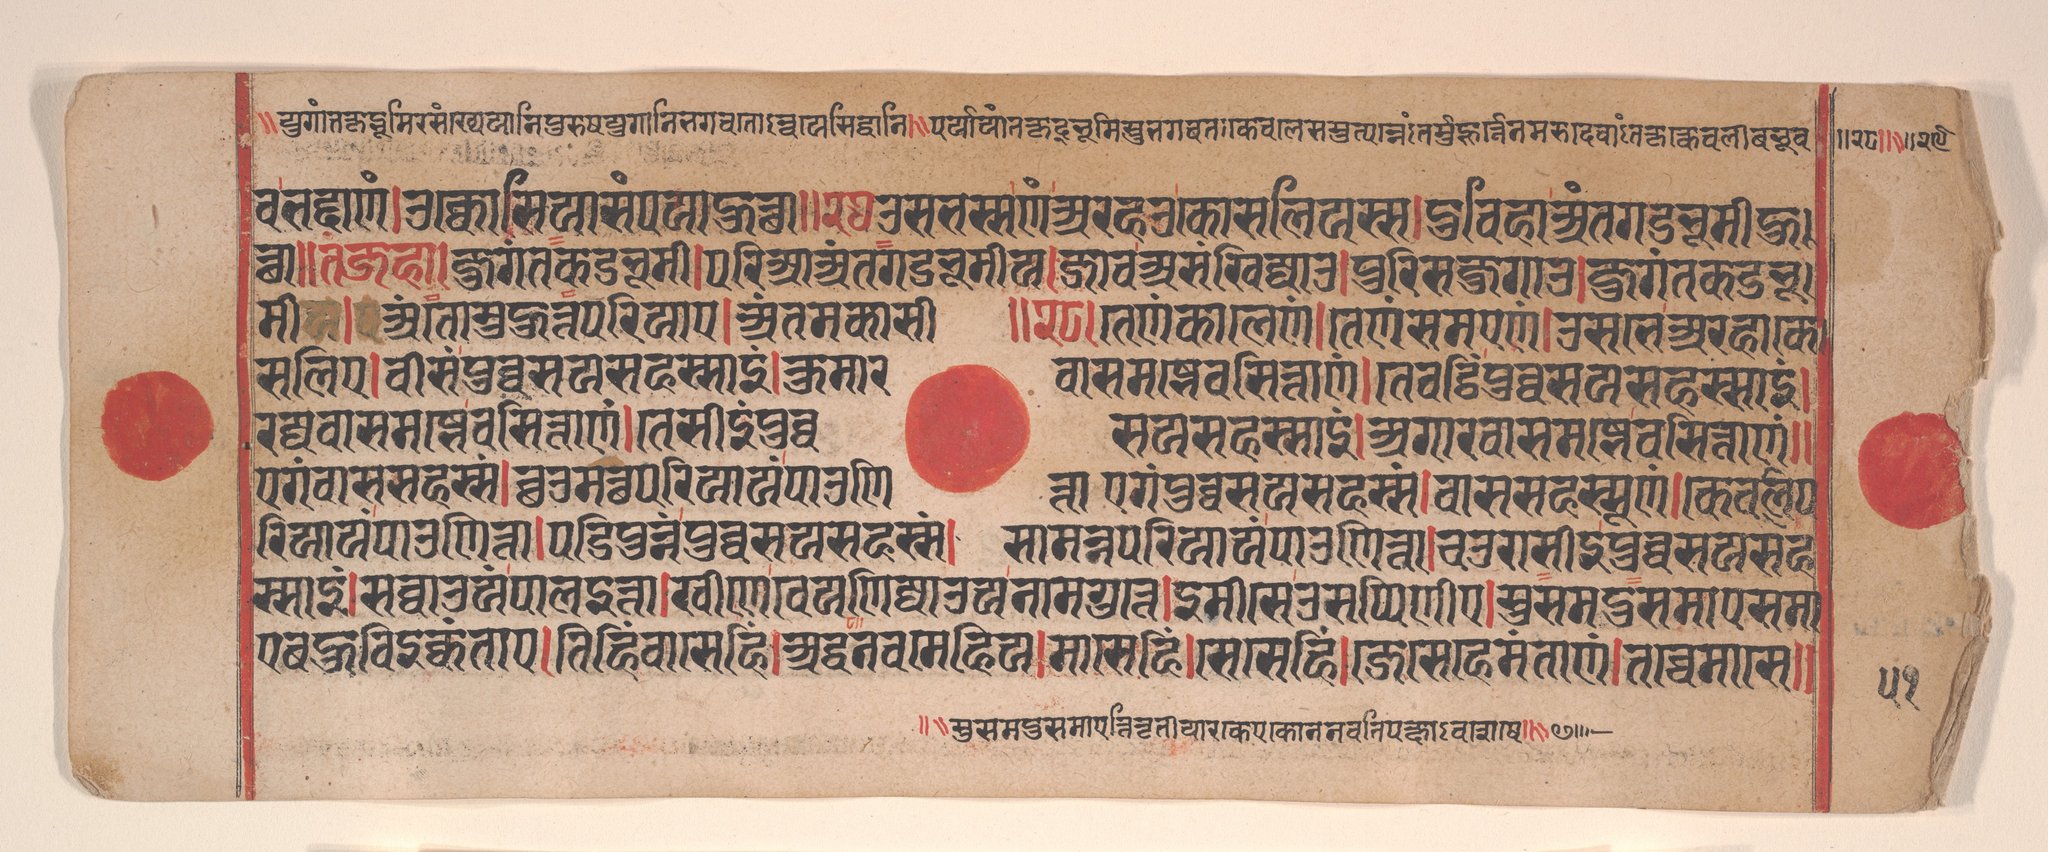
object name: folio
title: Leaf from a Kalpa Sutra (Jain Book of Rituals)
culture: indian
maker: bhadrabahu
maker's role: artist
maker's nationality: indian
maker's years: 356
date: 1401-1500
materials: gold, ink, paper, watercolor